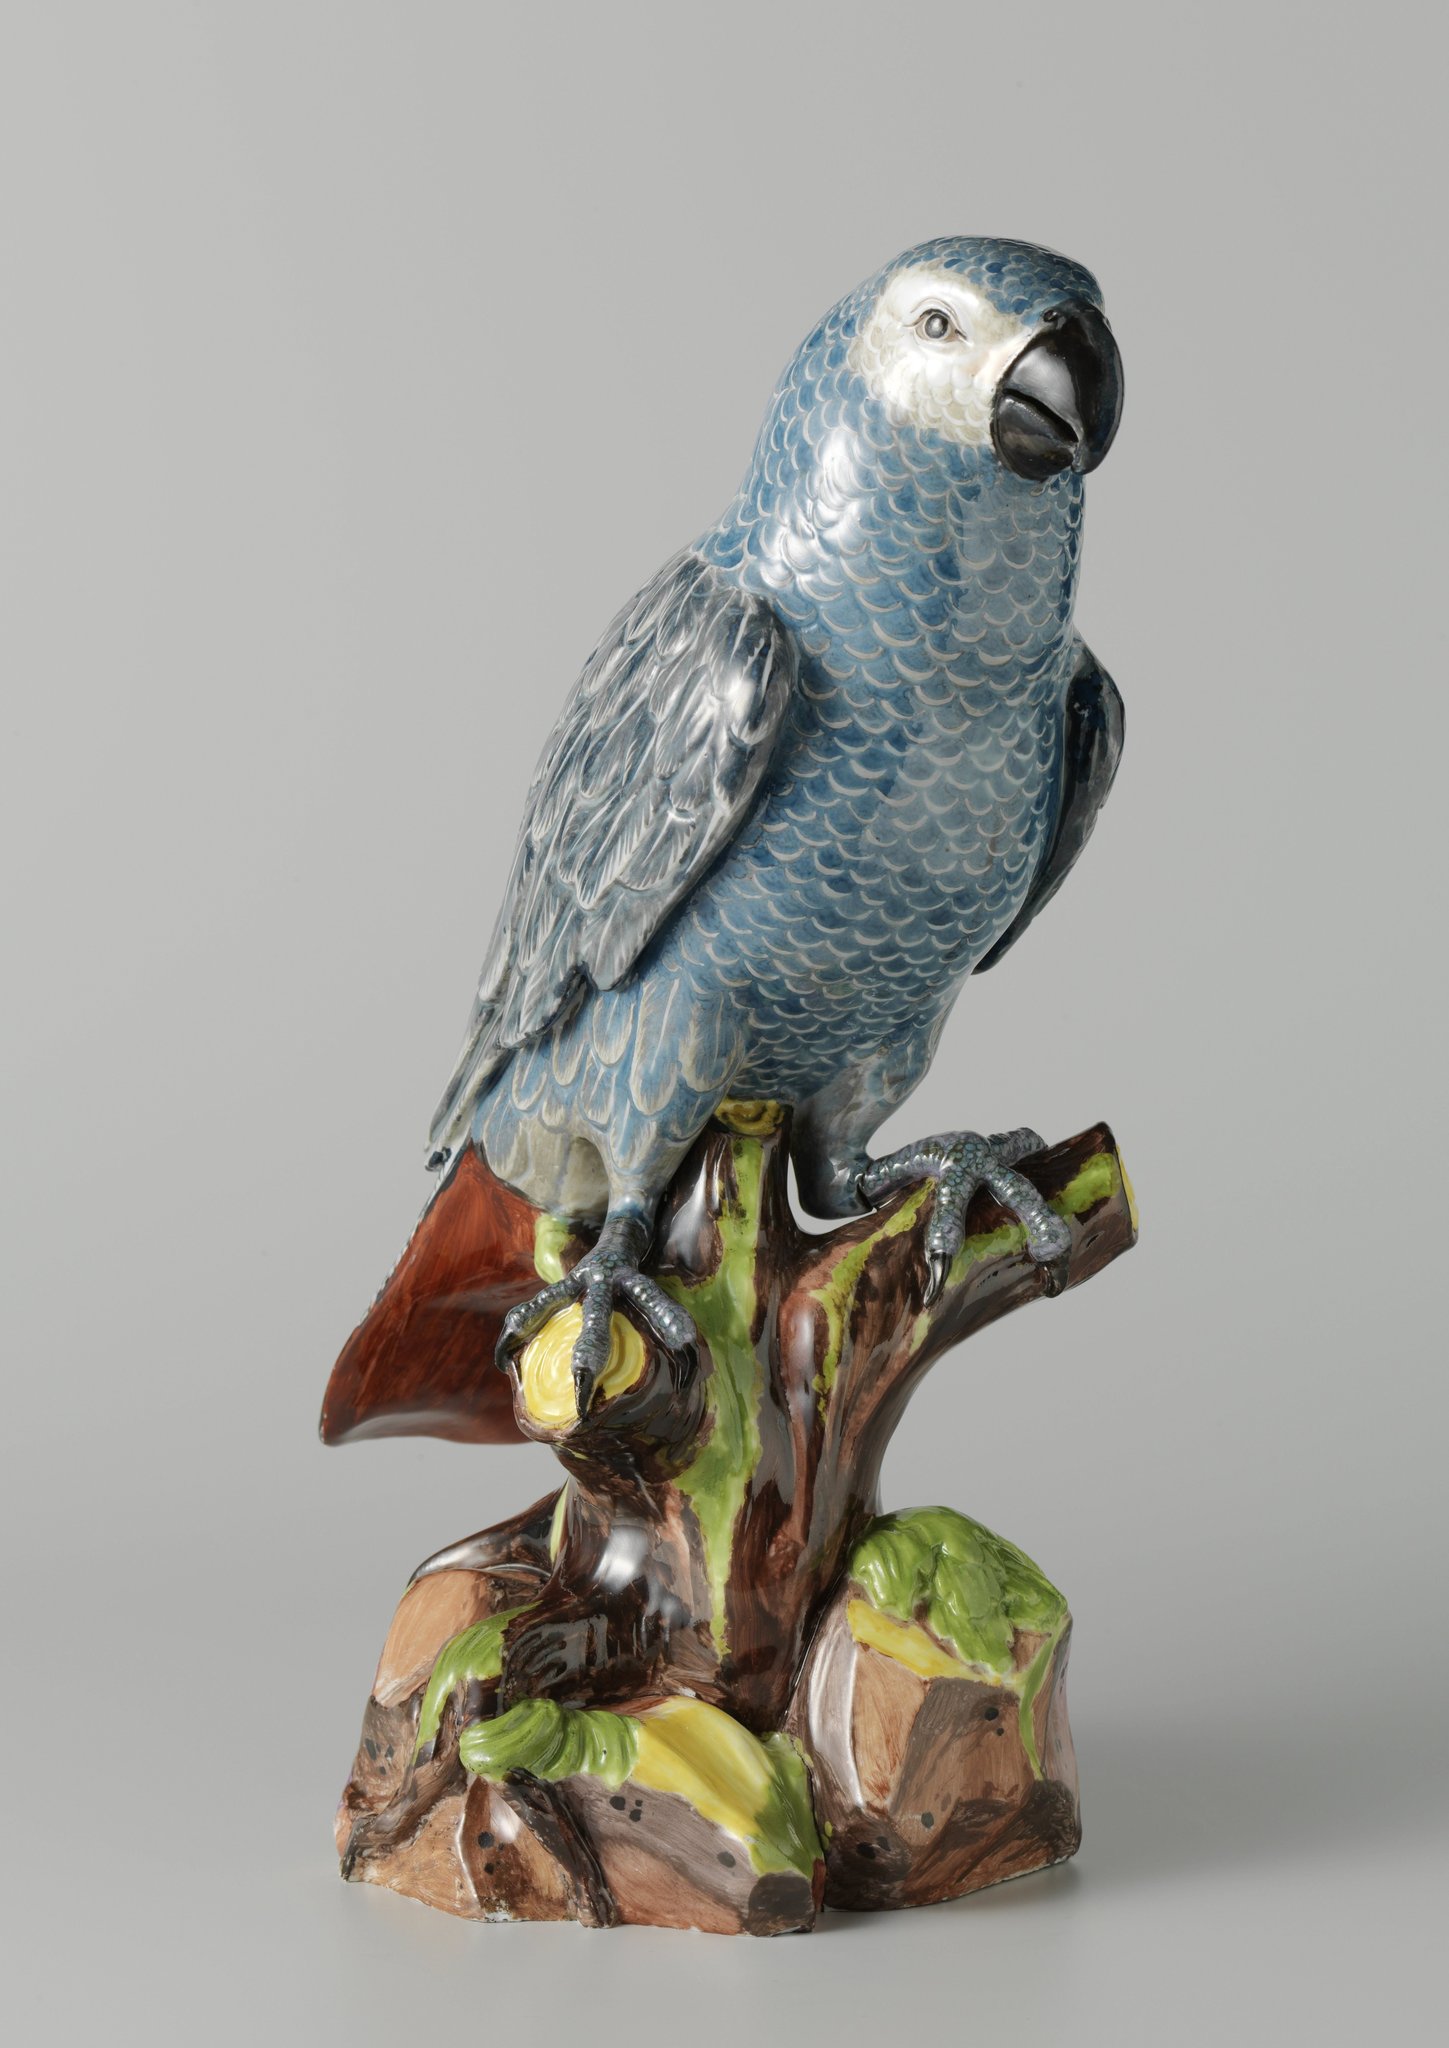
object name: figure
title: Blue Parrot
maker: johann joachim kändler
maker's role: designer, sculptor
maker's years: 1706-1775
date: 1730-1733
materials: porcelain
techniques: painted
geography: meissen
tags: ornamental birds: parrot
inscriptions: factory mark: ‘AR’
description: The porcelain factory at Meissen, near Dresden, was founded in 1709. It was the first European factory to produce ‘true’ or hard-paste porcelain, like that known in China and Japan. The manufactory was owned by Augustus the Strong, Elector of Saxony and King of Poland. All the birds and animals in this display case were made for him. They were intended for his so-called Japanese Palace, the walls of which he wished to fill with porcelain.